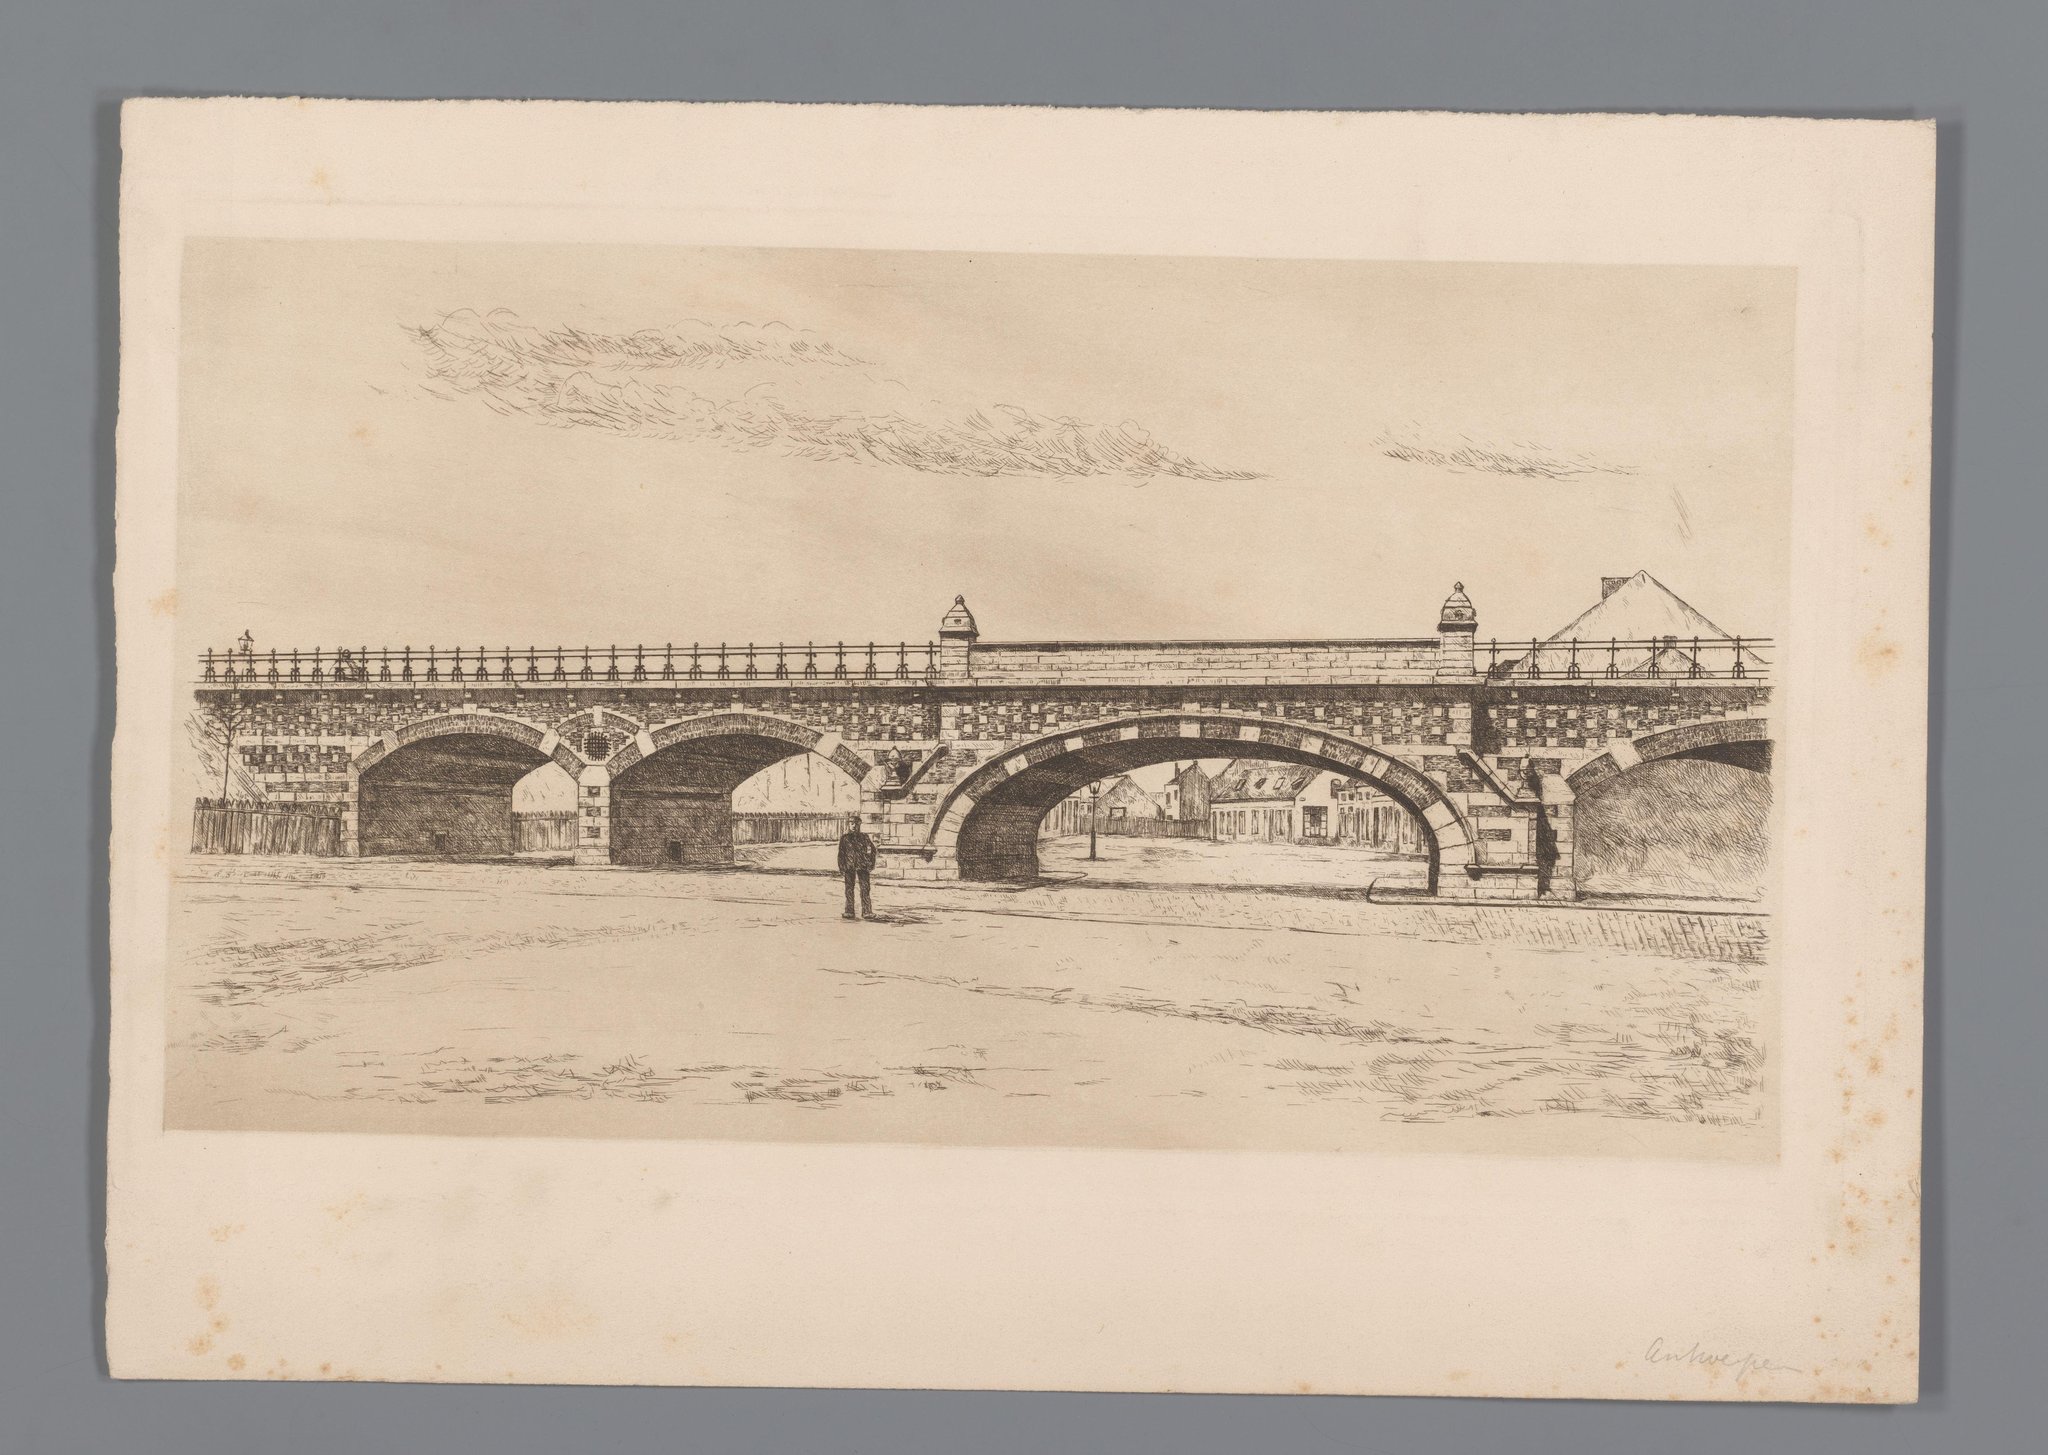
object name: book illustration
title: Portret van Giuseppe Ballo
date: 1635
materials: paper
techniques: engraving, letterpress printing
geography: padua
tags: historical persons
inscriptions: inscription: ‘Josephus Ballus. Sicul. Panormit. Sacerd. Doctorq[ue] Theologus’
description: Prent uit: Ballo, Giuseppe. De foecunditate dei circa productiones ad extra (...). Padua: Sebastiano Sardi, 1635.